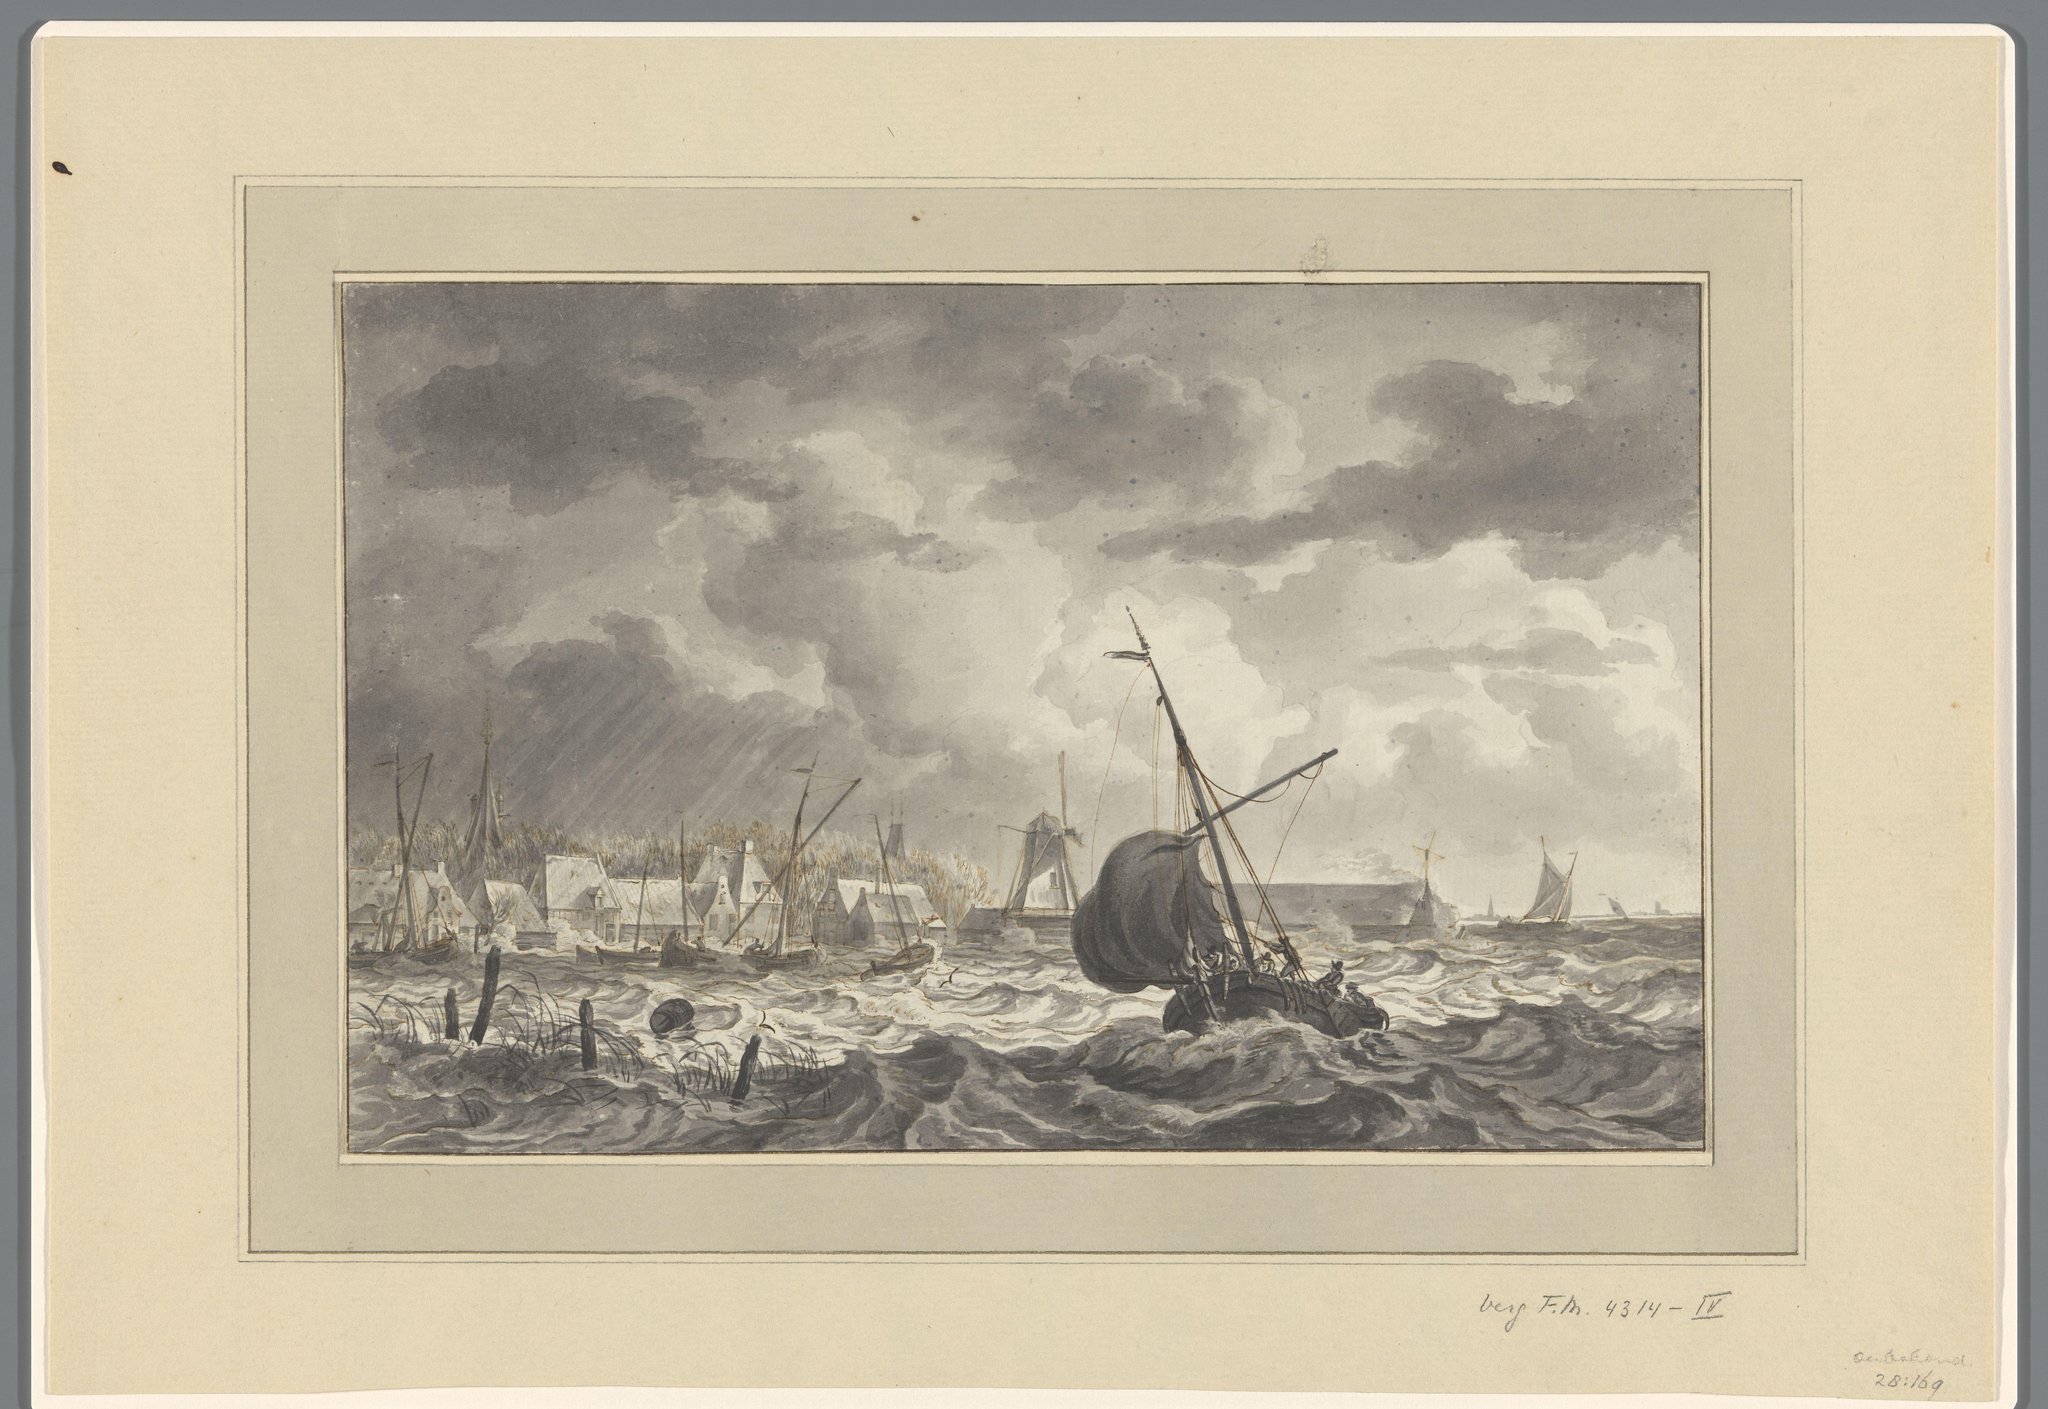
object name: drawing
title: Storm en hoogwater bij Elburg, 21 november 1776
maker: Anonymous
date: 1776-1822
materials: ink, paper, pencil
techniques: brush, pen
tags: flood, historical events and situations